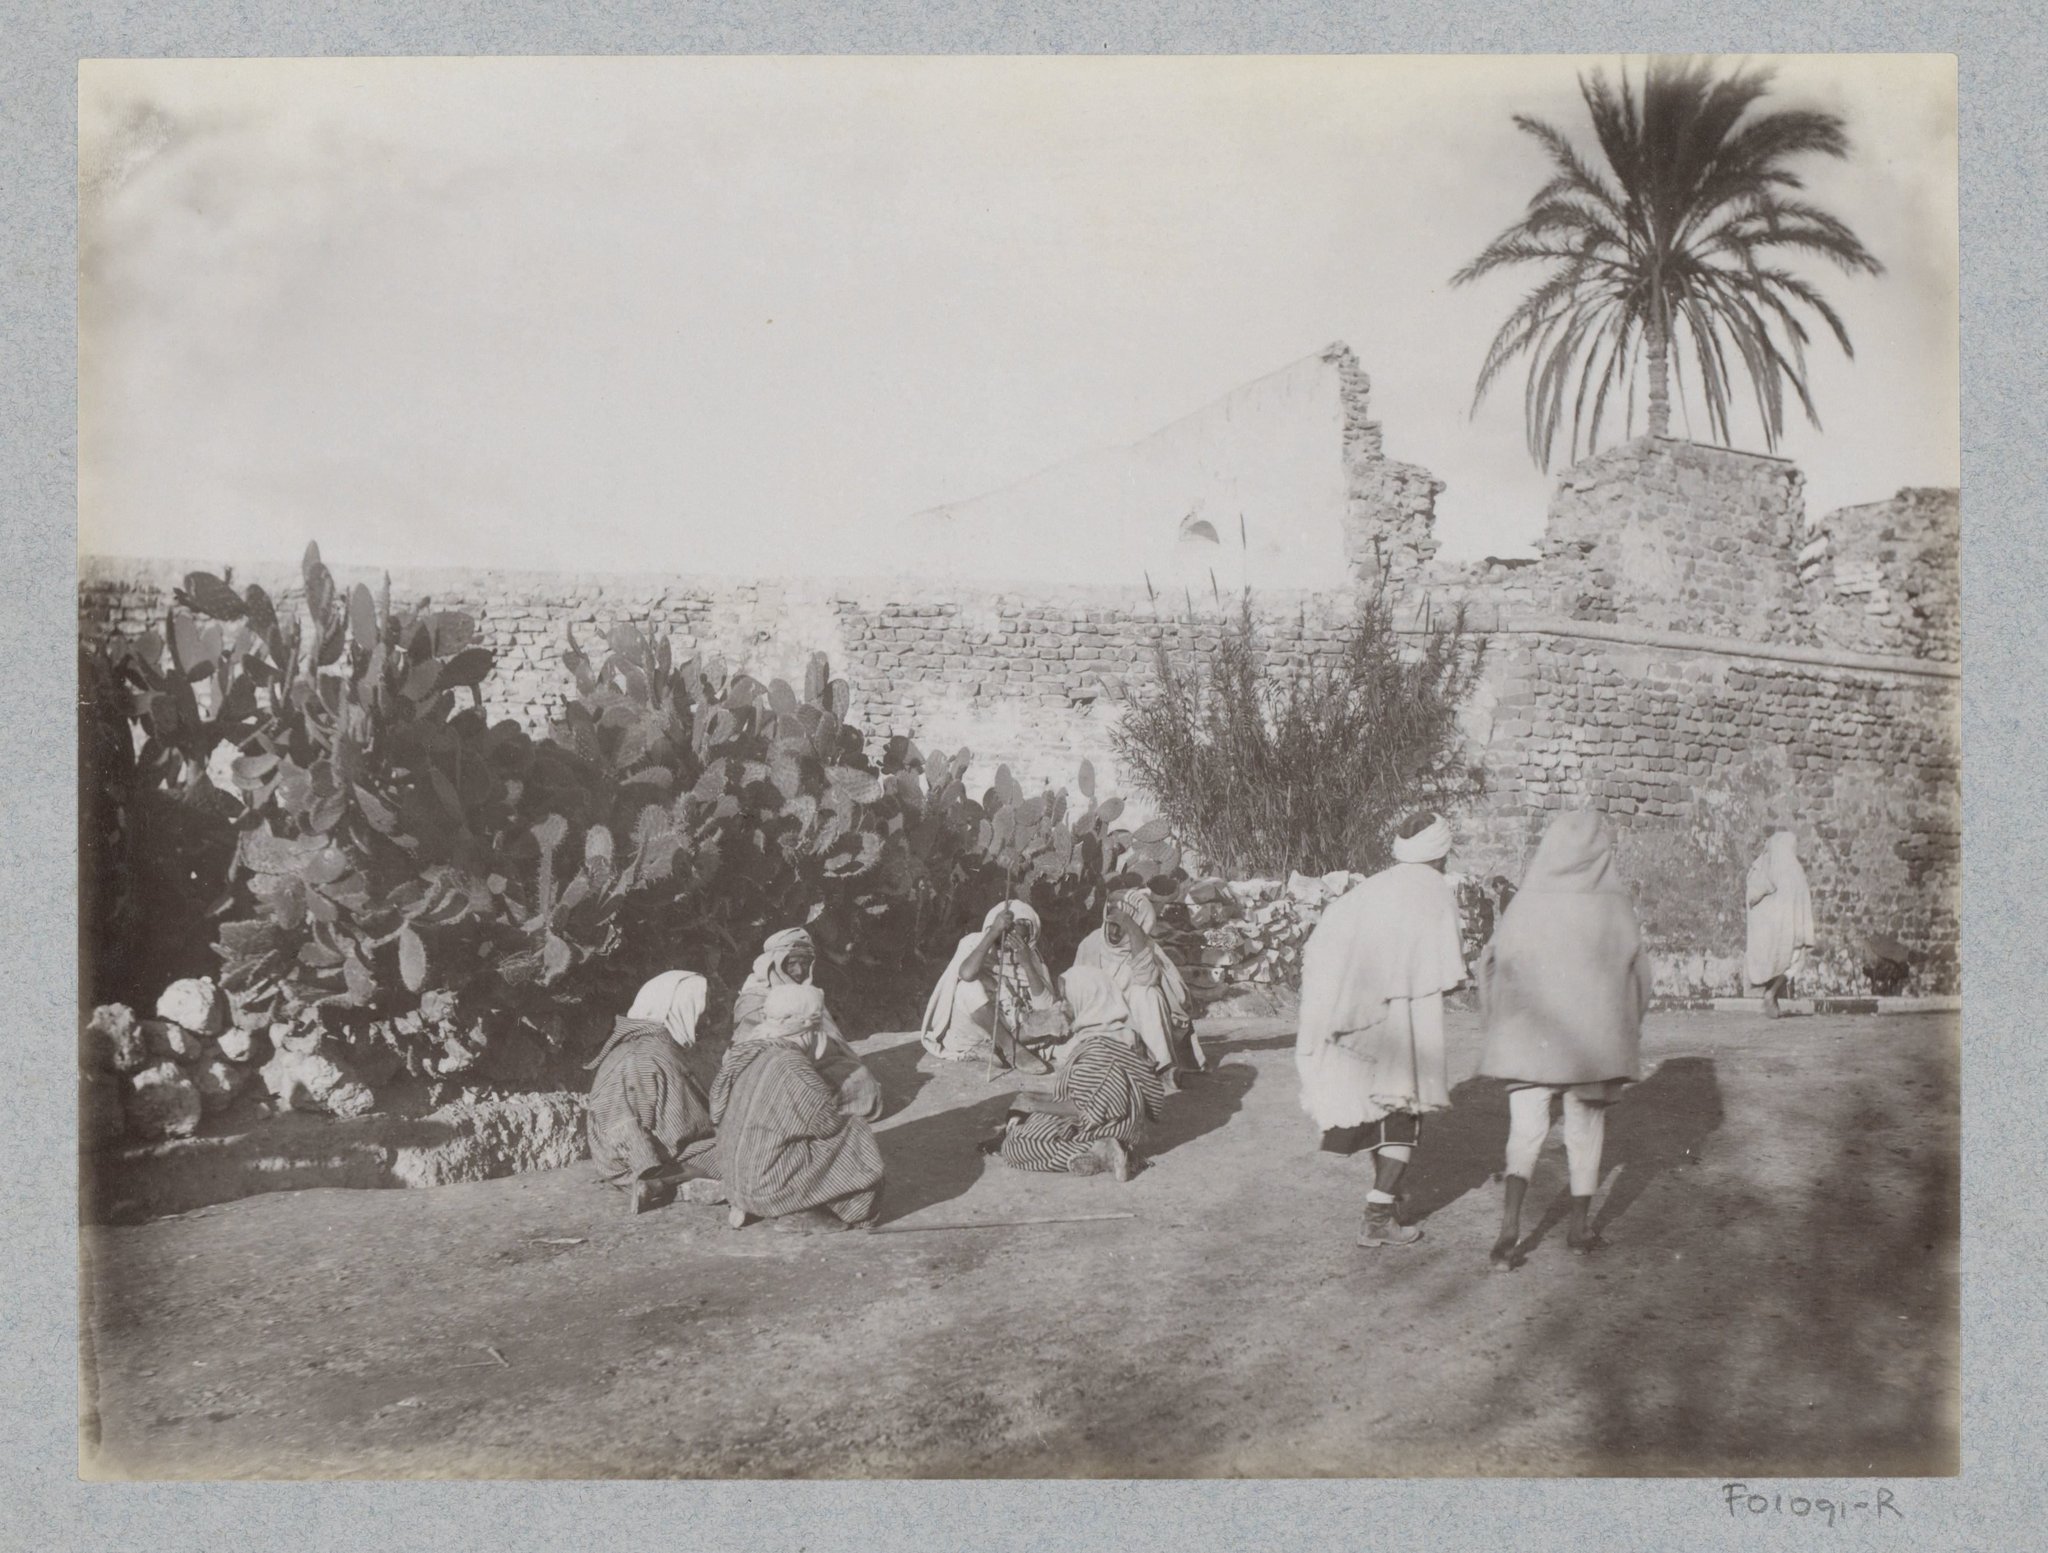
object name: album leaf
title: Arabieren bij (vermoedelijk) de stadsmuur van Tunis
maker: Anonymous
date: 1880-1900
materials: paper, photographic support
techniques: albumen print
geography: tunis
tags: walls ~ fortified city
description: Onderdeel van Reisalbum met foto's van bezienswaardigheden in Tunis en Tunesië.